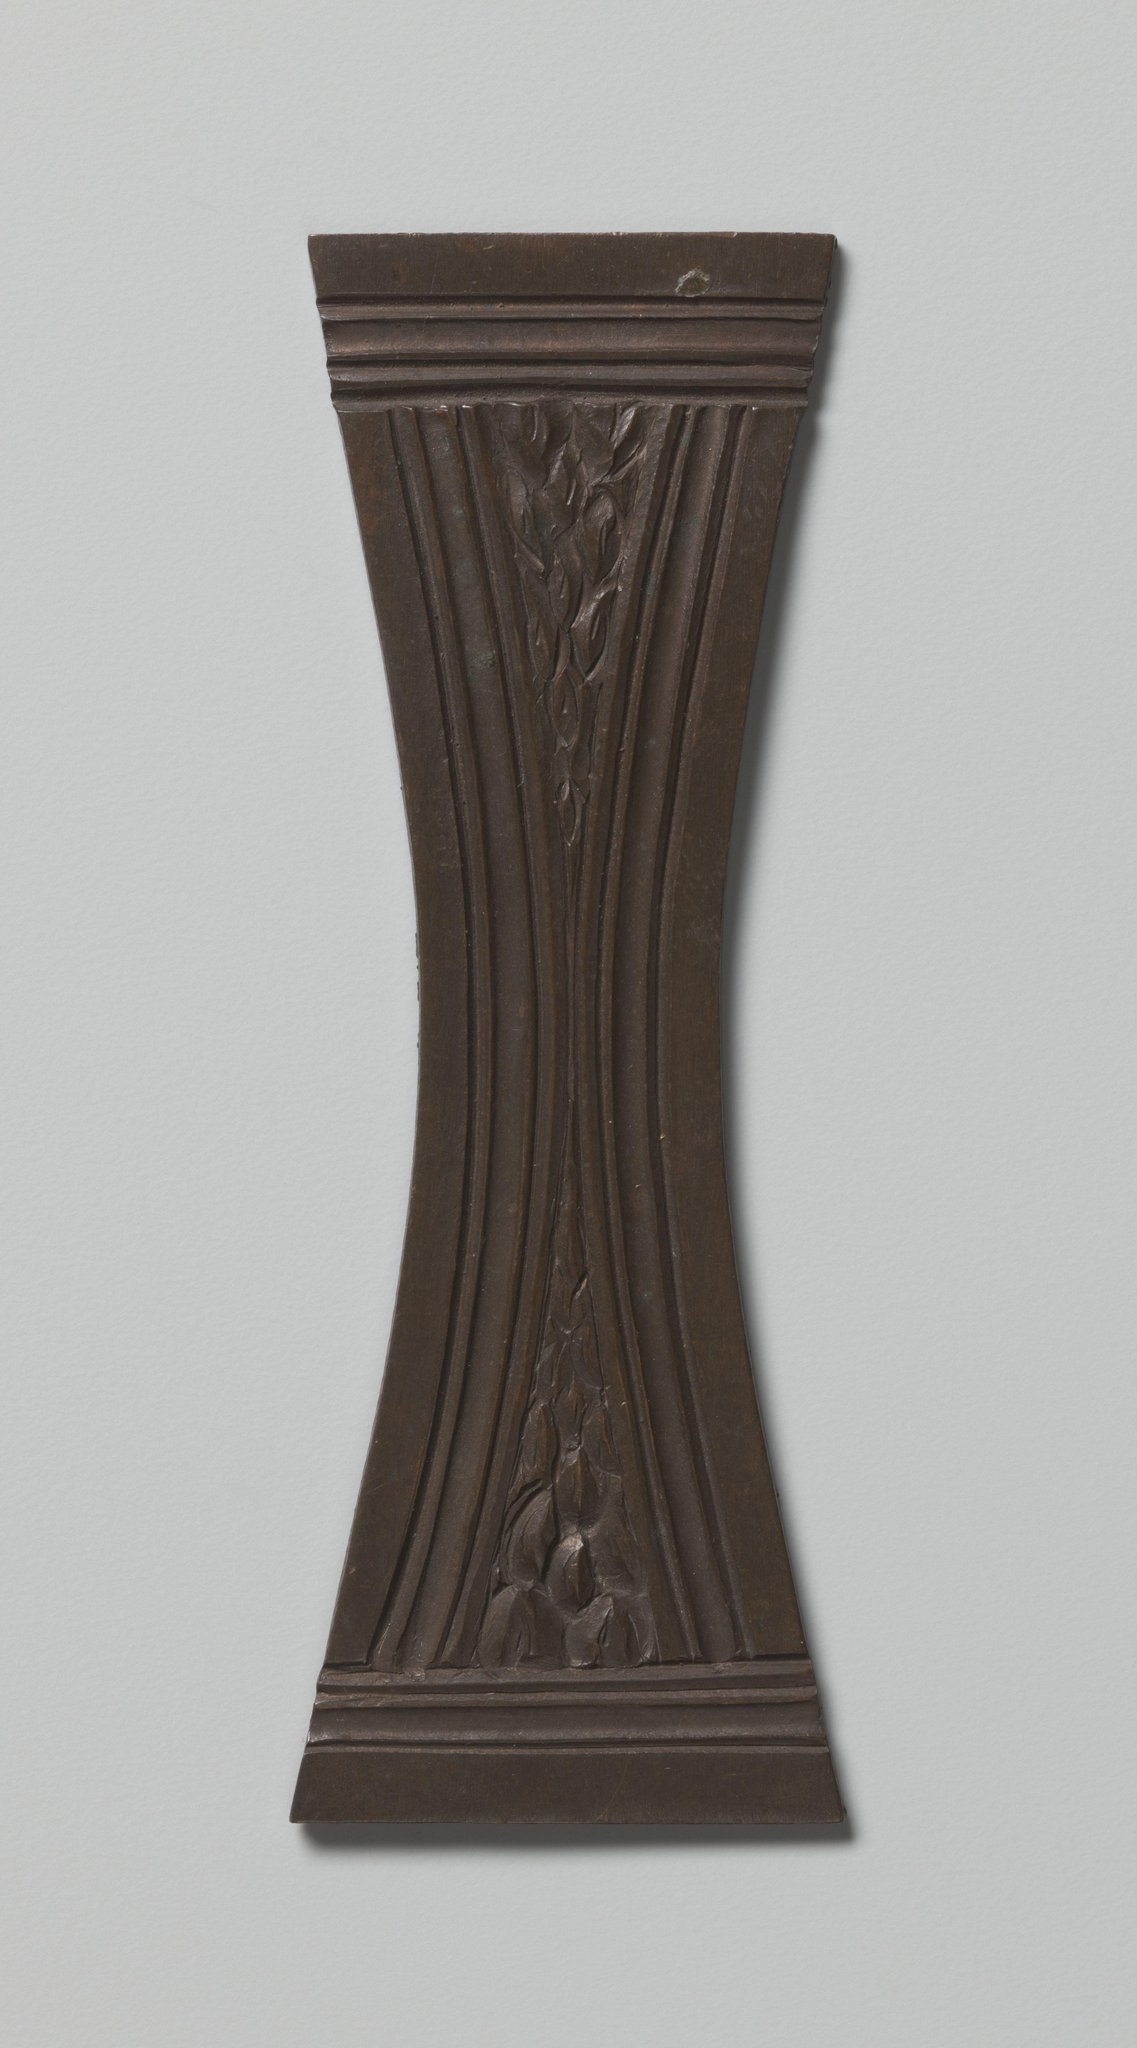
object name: hasp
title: Model voor een beugel van een boekslot met geprofileerde randen en bladeren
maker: Anonymous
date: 1775-1800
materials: copper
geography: amsterdam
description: In het uit plaat gemaakte model voor een gietvorm zijn geprofileerde randen uitgesneden, waartussen bladeren.